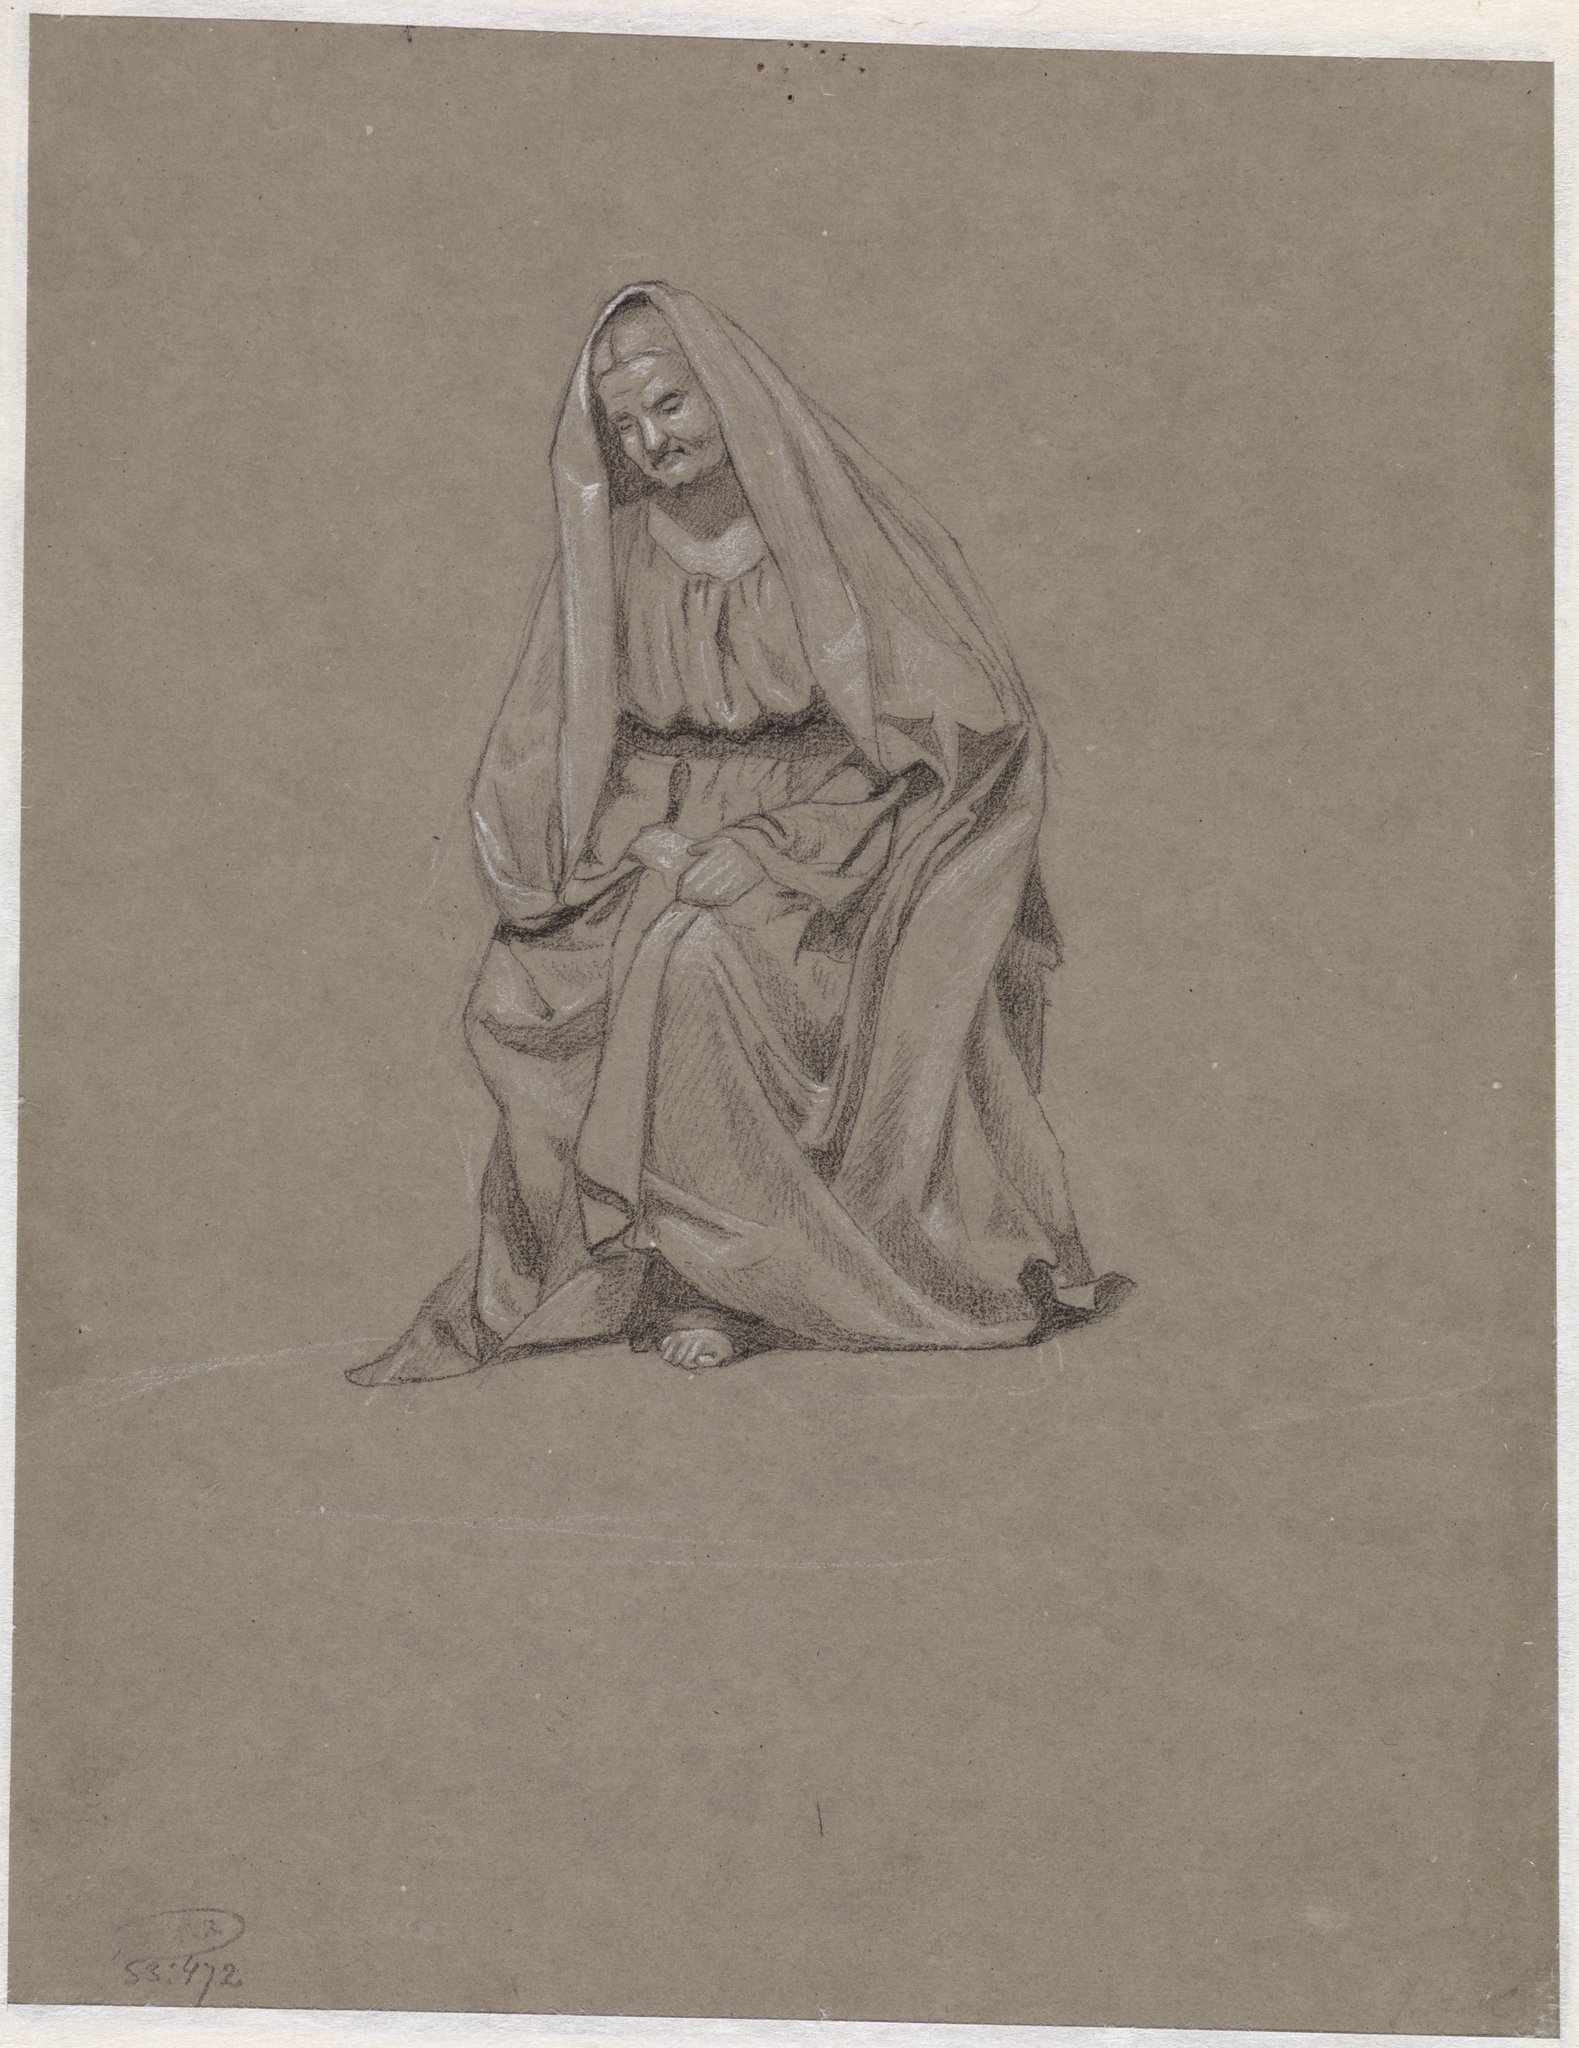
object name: drawing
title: Zittende vrouw met mantel over hoofd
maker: johan hendrik koelman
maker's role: draughtsman, print maker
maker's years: 1820-1887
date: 1830-1887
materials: chalk, paper, pencil